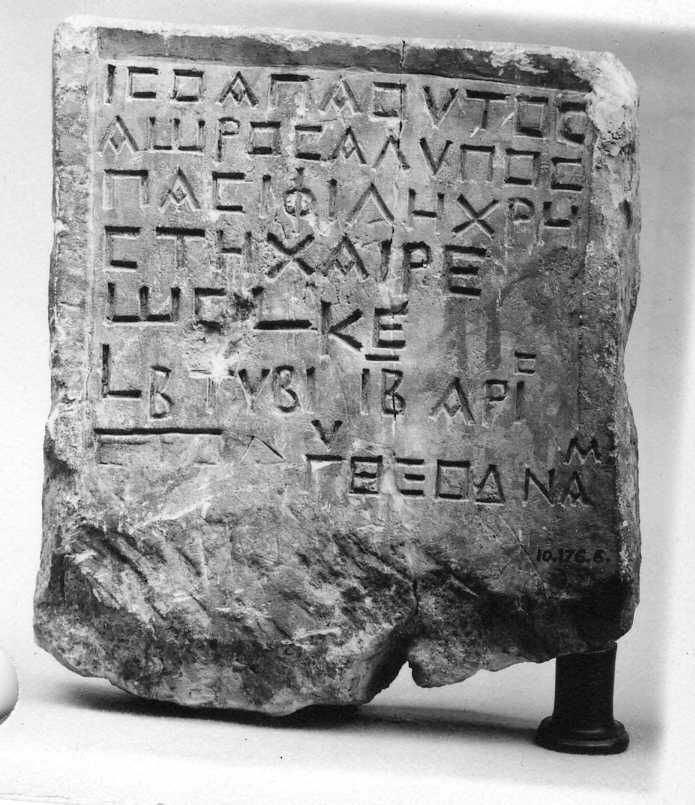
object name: stele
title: Inscribed Stele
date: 201-1200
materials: limestone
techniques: incising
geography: egypt